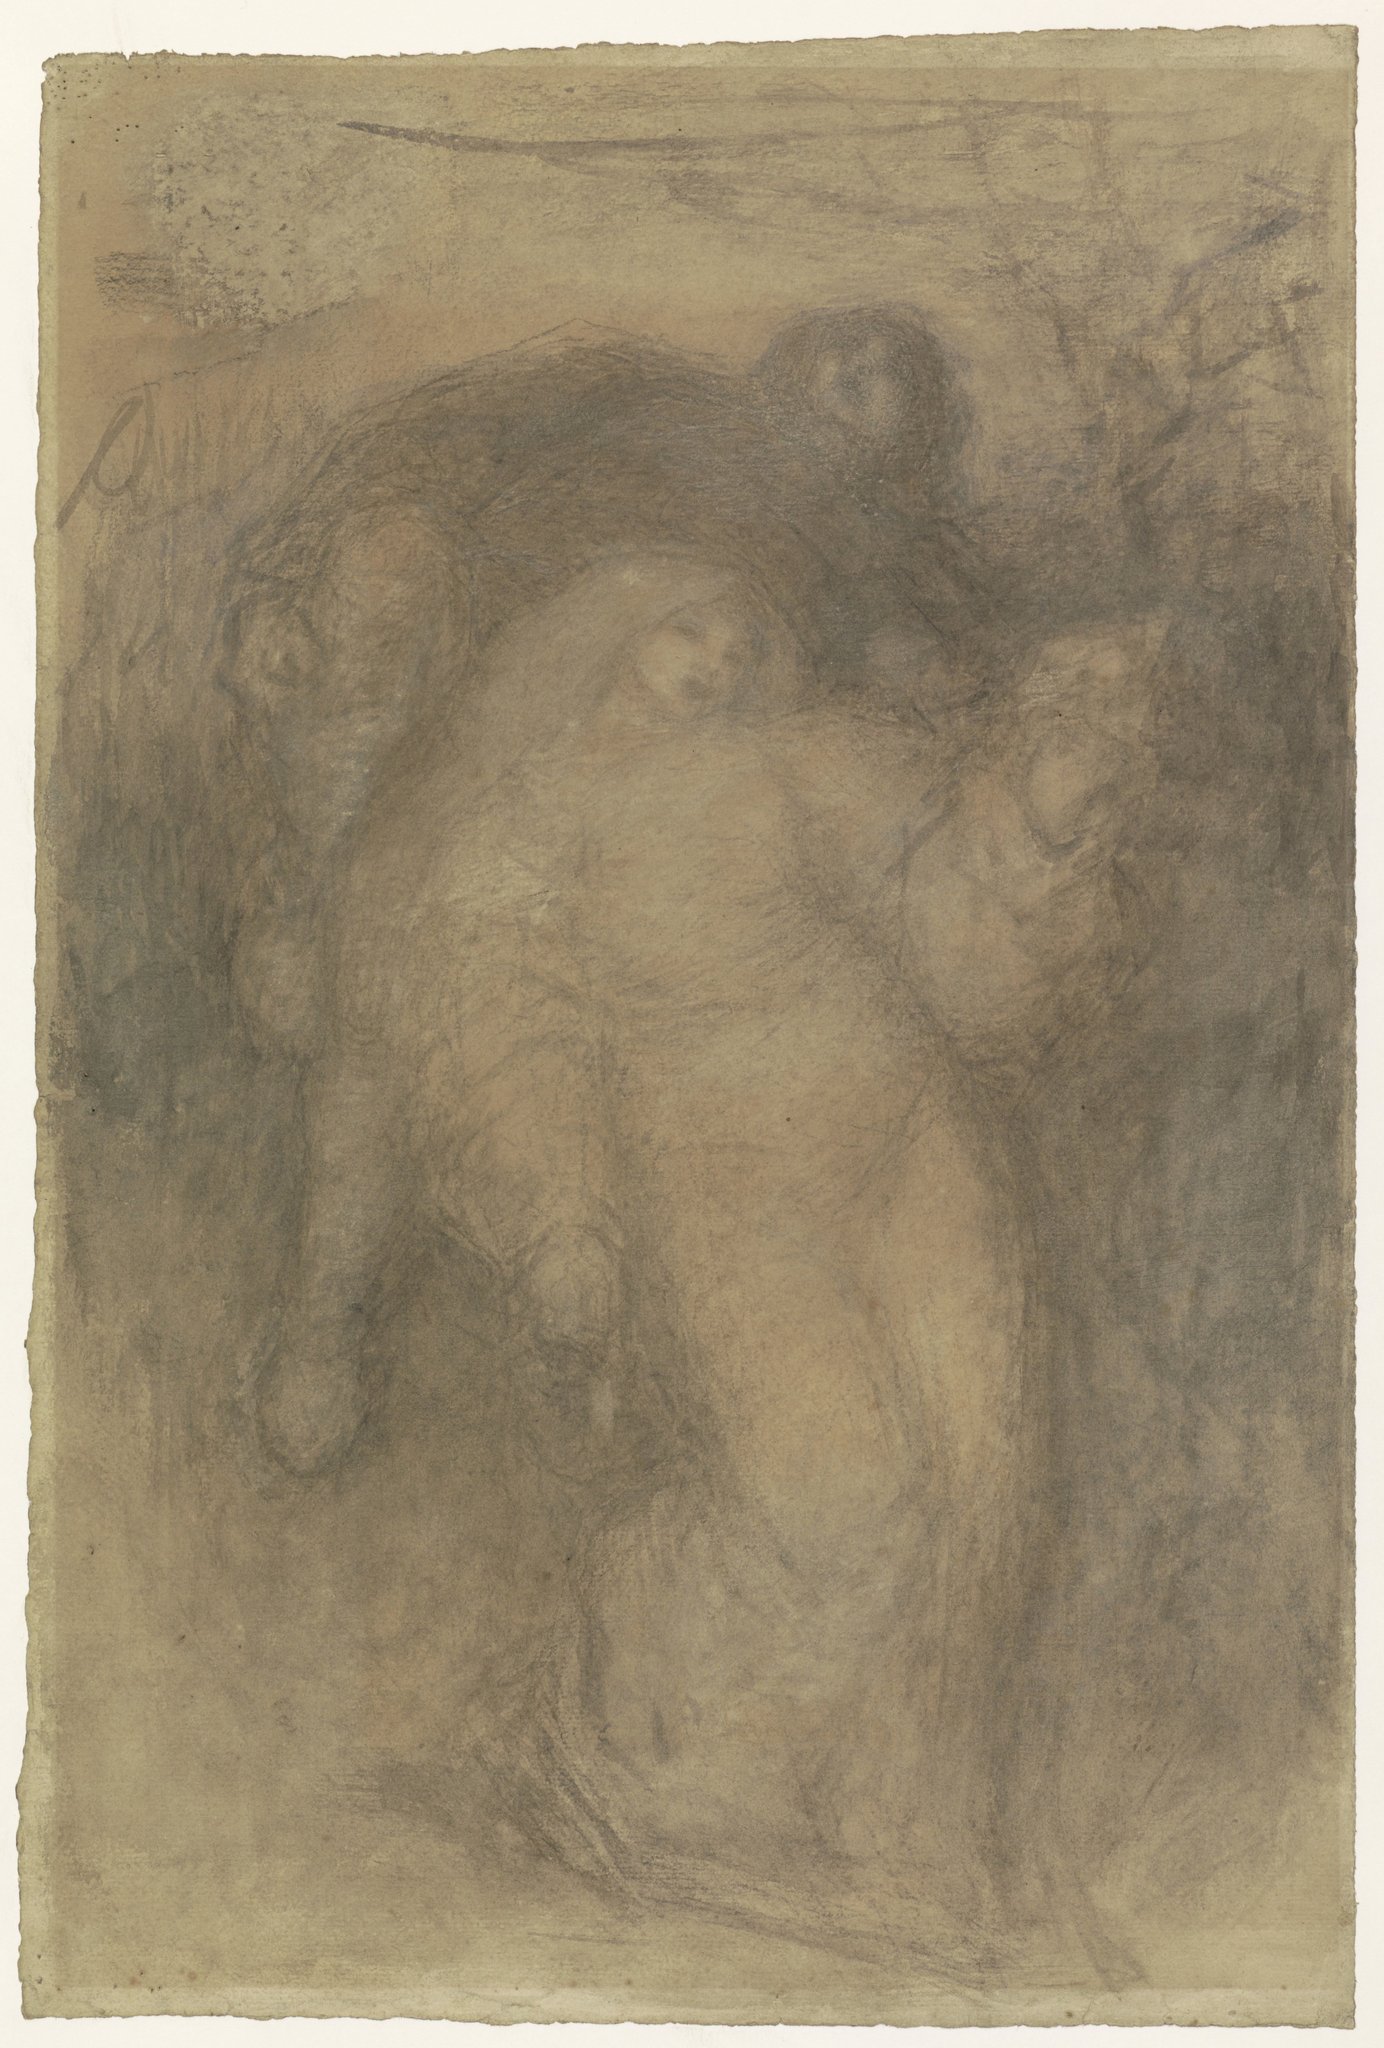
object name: drawing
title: Peace (Preliminary Study)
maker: matthijs maris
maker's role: draughtsman, painter, print maker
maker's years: 1839-1917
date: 1899-1900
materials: chalk, paper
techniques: brush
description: Jong paar, getekend op de achterkant van een ets.